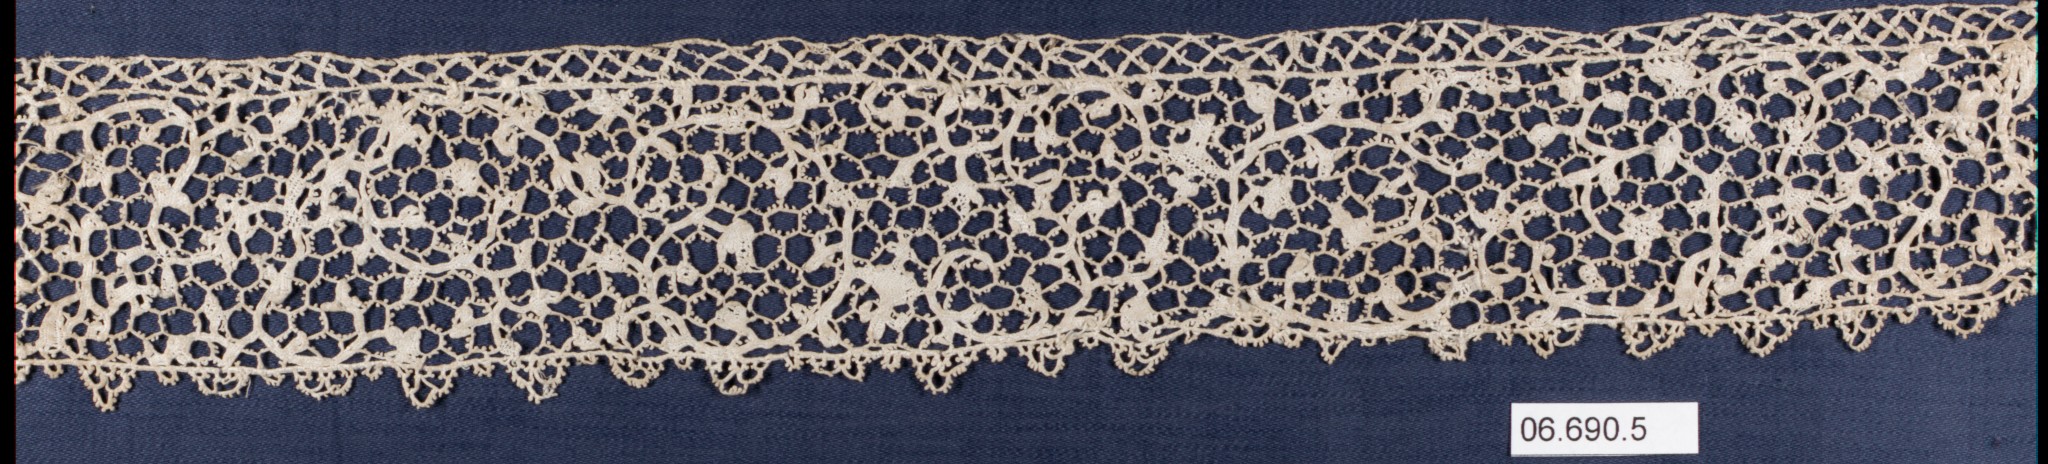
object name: fragment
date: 1701-1733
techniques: lace